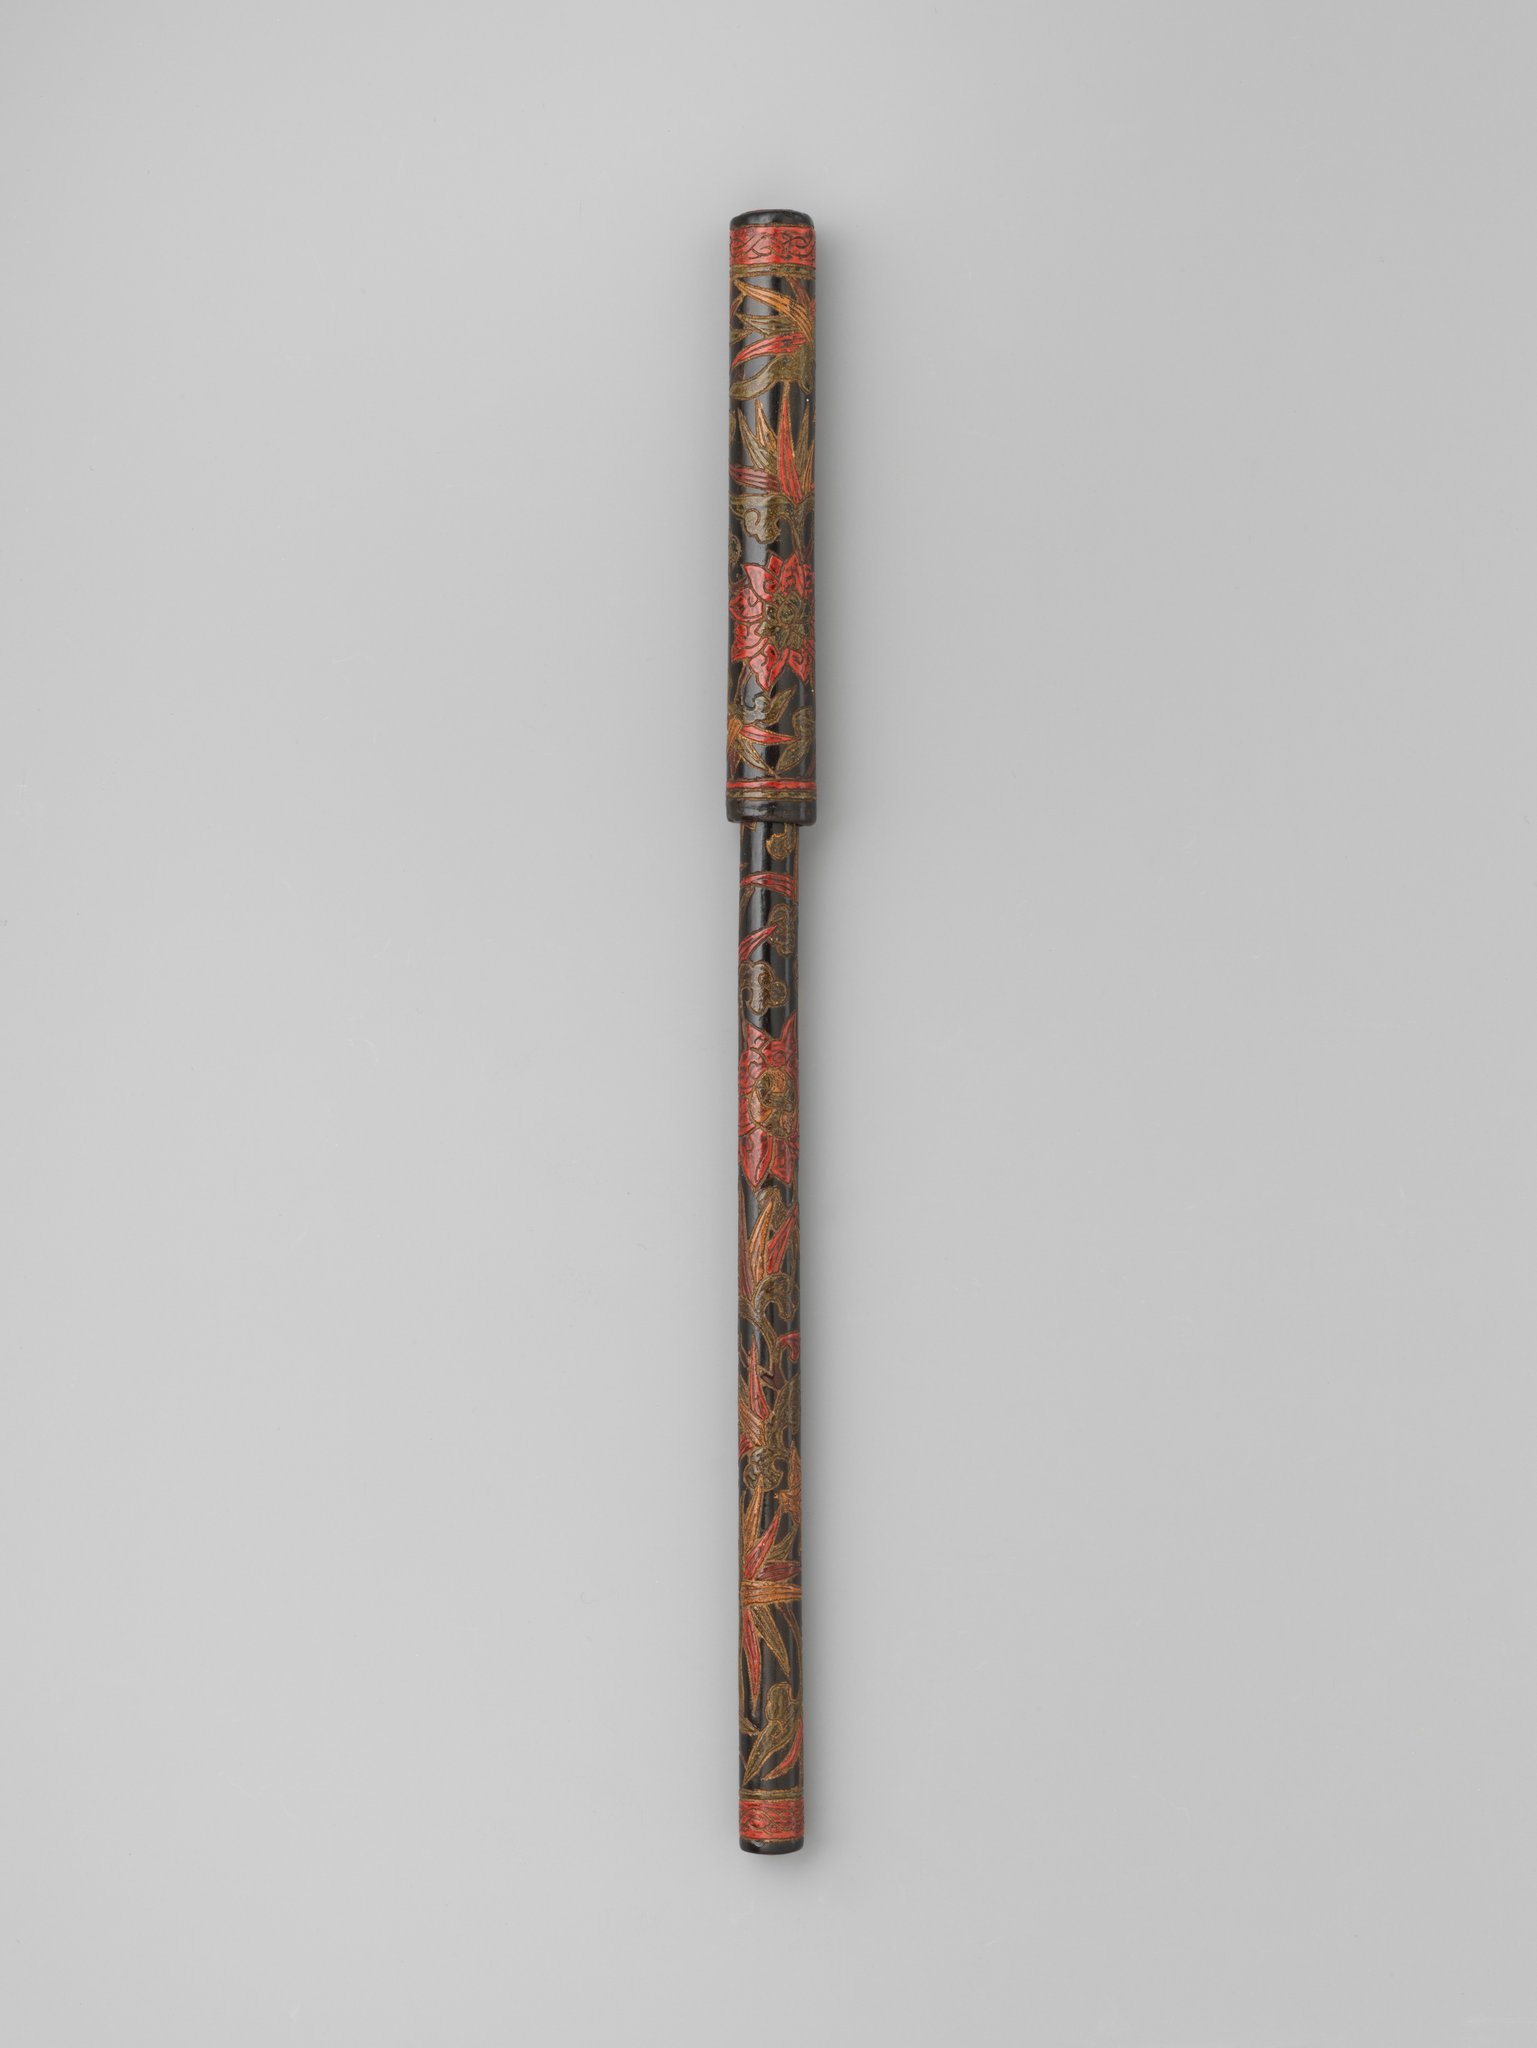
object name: writing brush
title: Brush and cover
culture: chinese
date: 1601-1700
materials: lacquer